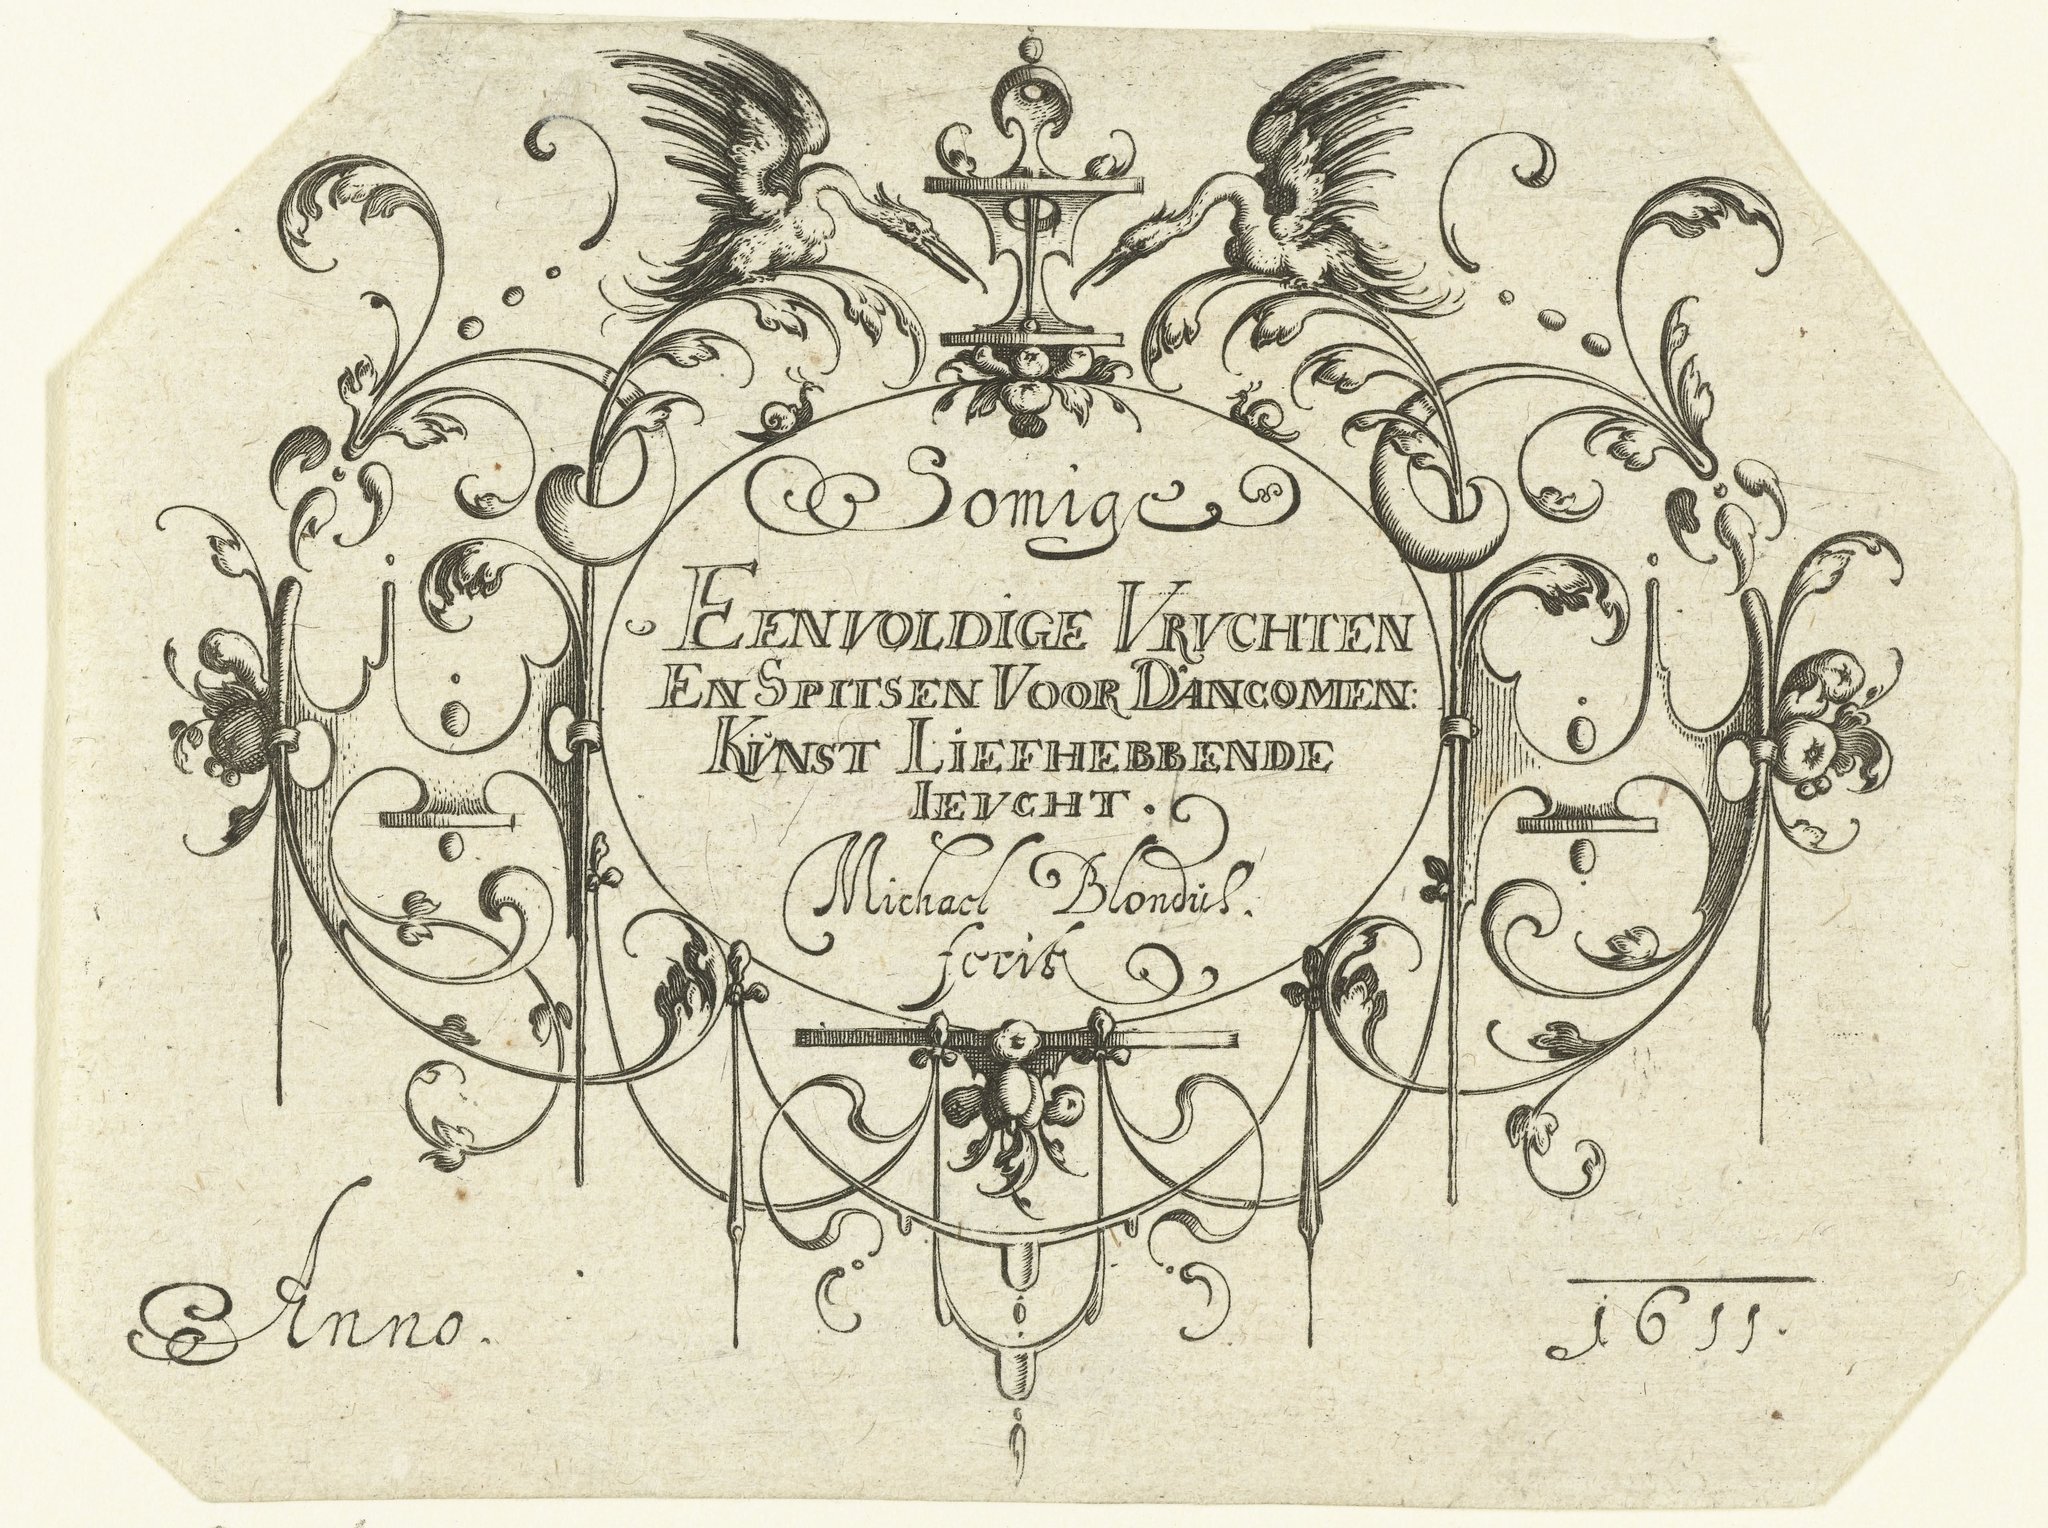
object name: titelblad, titelpagina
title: Somige Eenvoldige Vruchten en Spitsen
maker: michiel le blon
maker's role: print maker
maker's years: 1587-1656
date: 1611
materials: paper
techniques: etching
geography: amsterdam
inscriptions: date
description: Titelblad uit serie van 14 bladen met voorbeelden voor gegraveerde decoratieranden van bekers in de vorm van driehoeken bestaande uit ranken, Schweifwerk, guirlandes met putti, dieren, vogels en maskers.